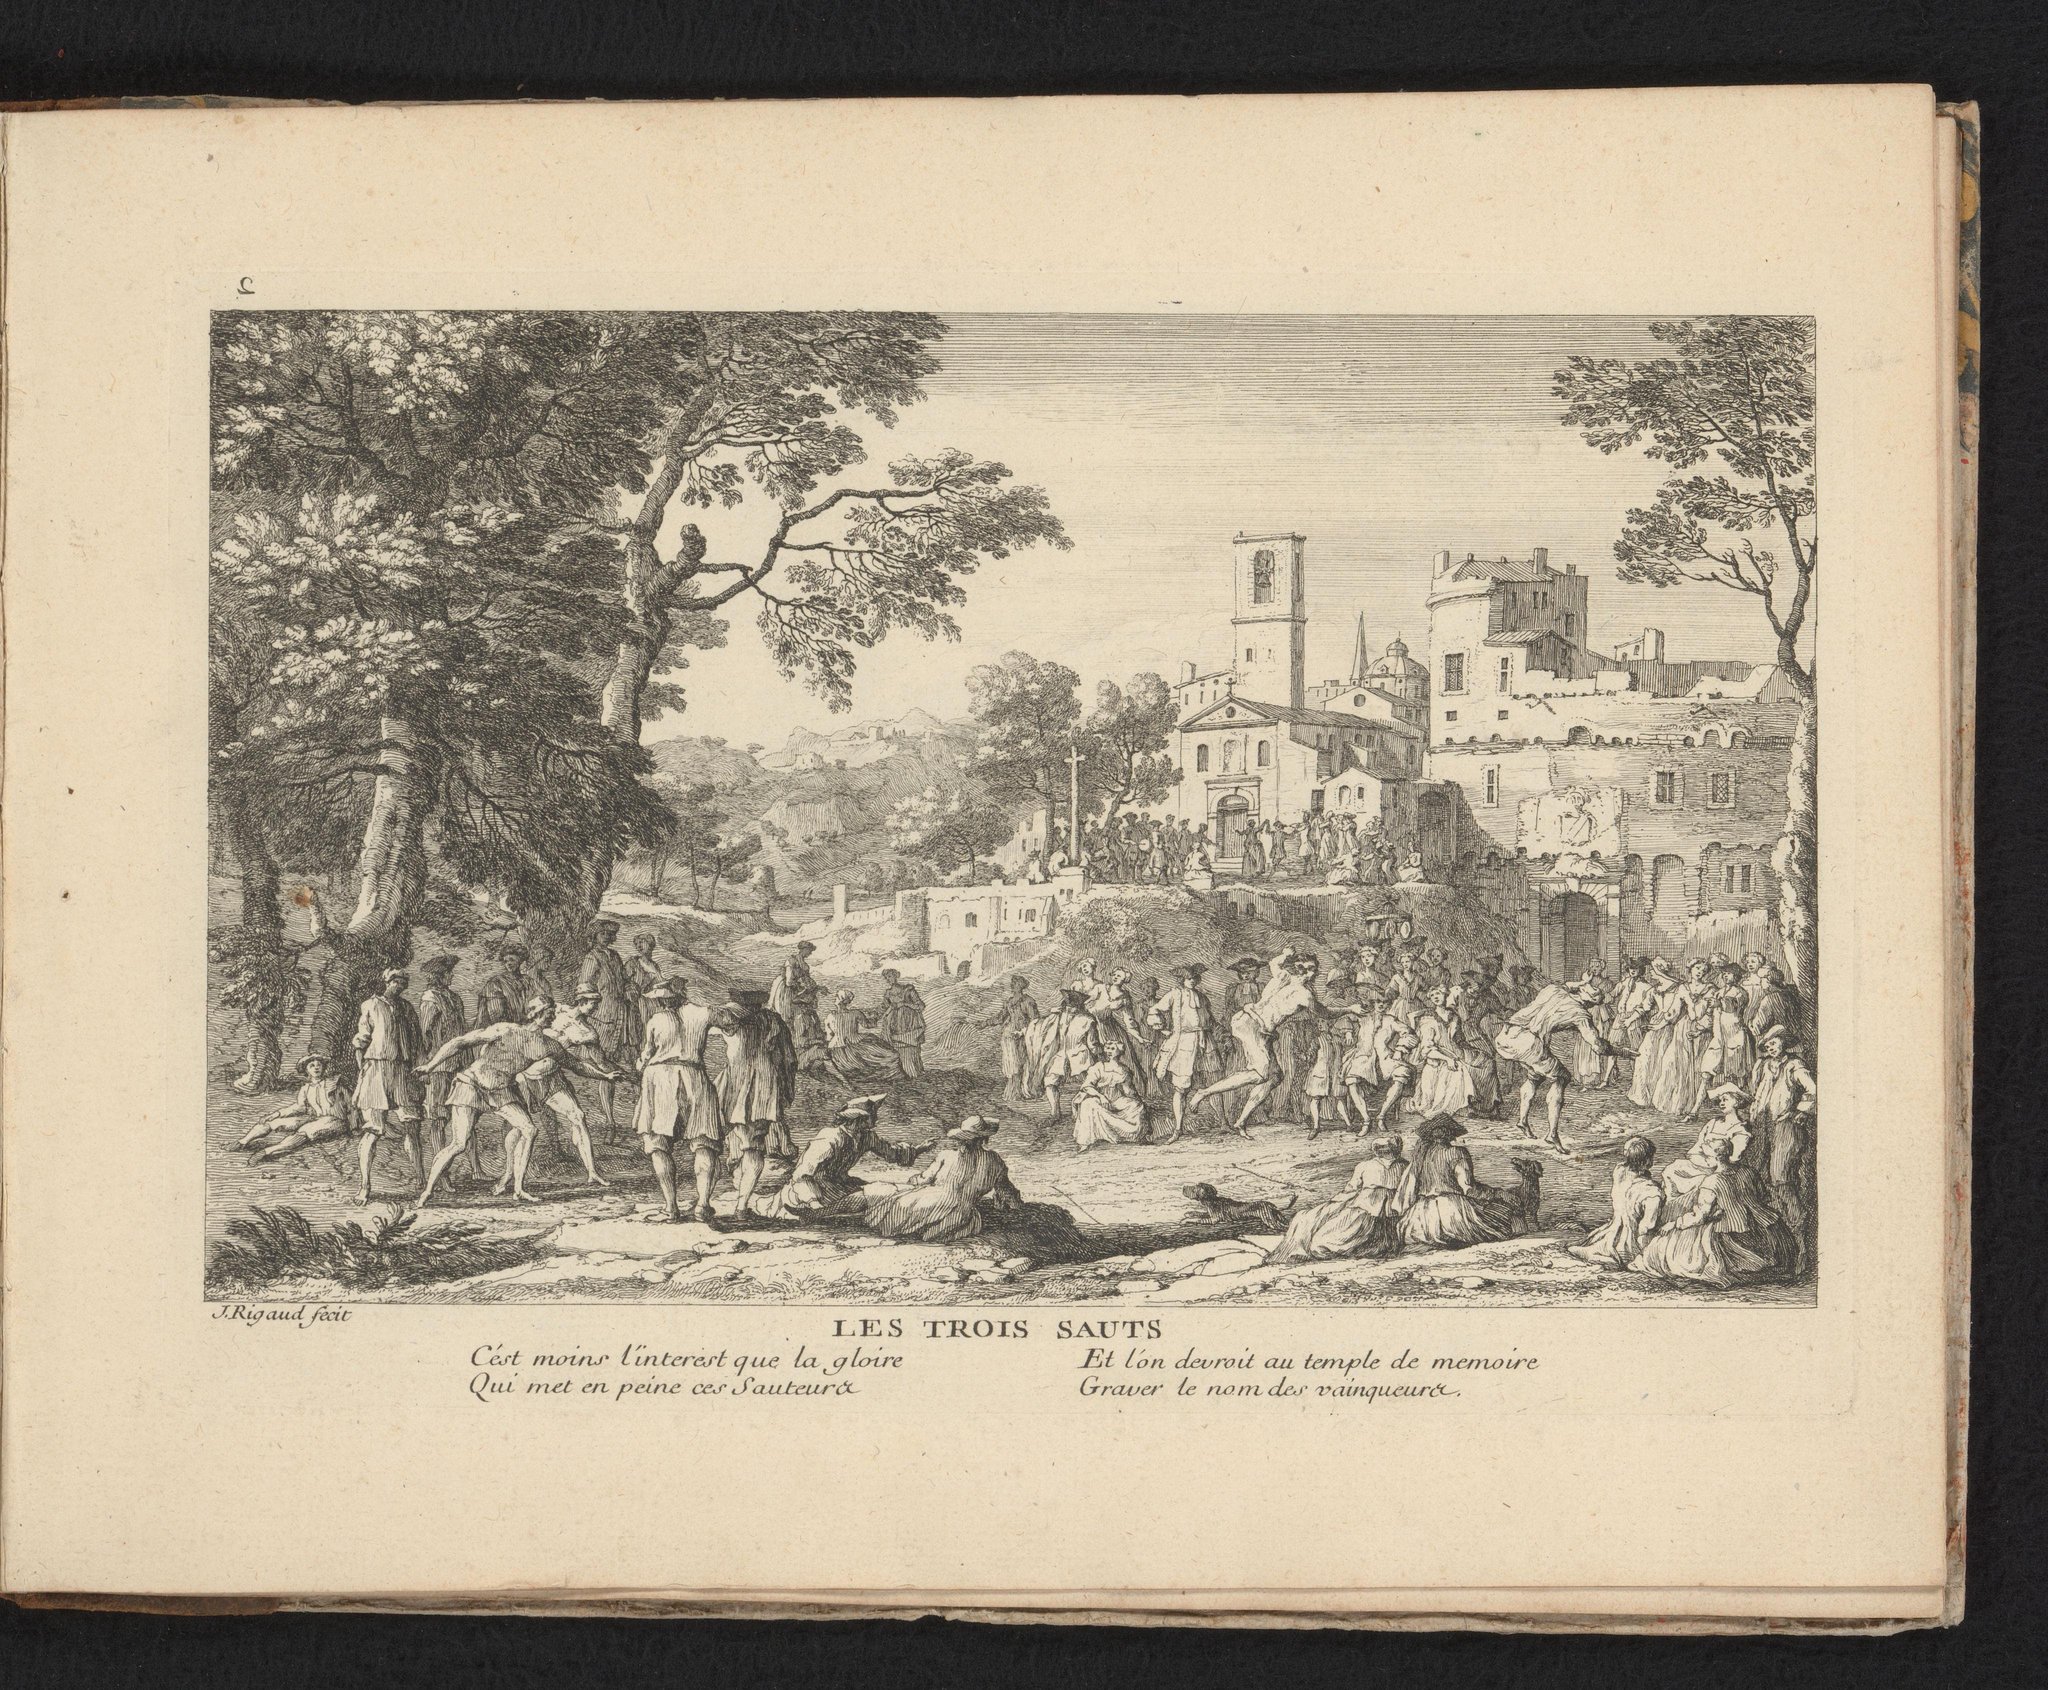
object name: album leaf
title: La trois sauts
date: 1700-1725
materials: paper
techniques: etching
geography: paris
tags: long-jumping, broad-jumping, folk dancing (men and women together), church (exterior)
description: Deze prent maakt deel uit van een album.